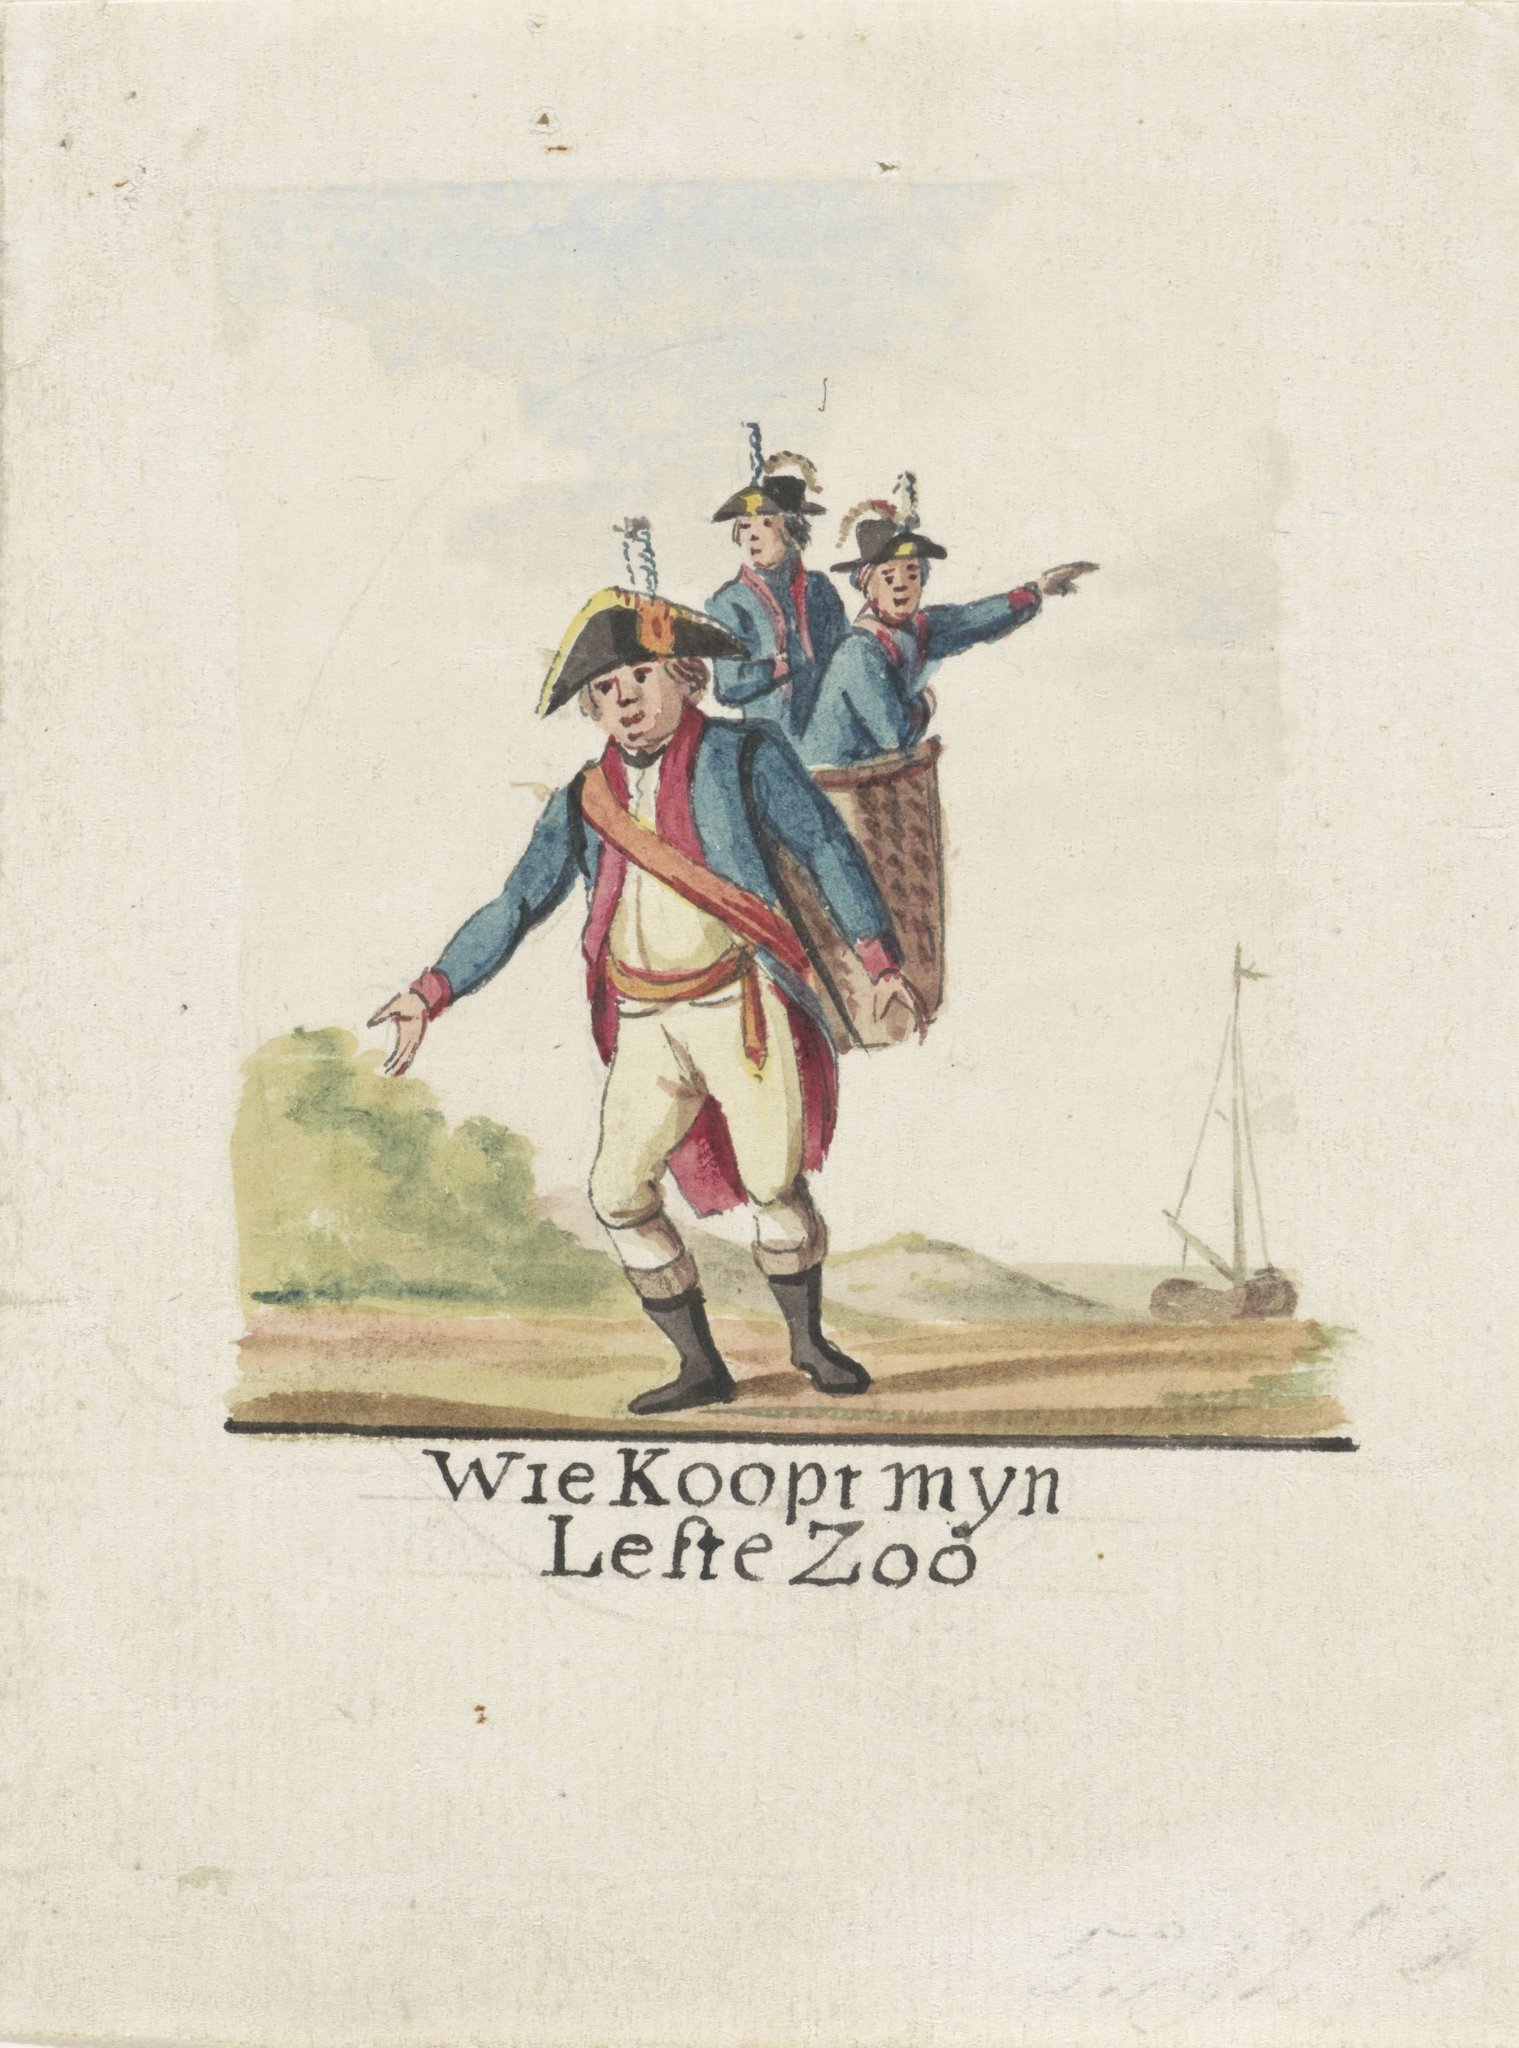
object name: cartoon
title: Spotprent op de Landzaten, 1795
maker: Anonymous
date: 1795-1796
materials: paint, paper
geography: northern netherlands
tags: wandering or travelling merchant, political caricatures and satires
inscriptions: collector's mark: Lugt 2228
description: Spotprent op de prinsgezinde landzaten die waardeloos bleken tijdens de Franse inval in 1795. Een patriots militair draagt een mand op zijn rug waarin twee landzaten zitten die hij te koop aanbiedt al roepend: Wie Koopt myn Leste Zoo.